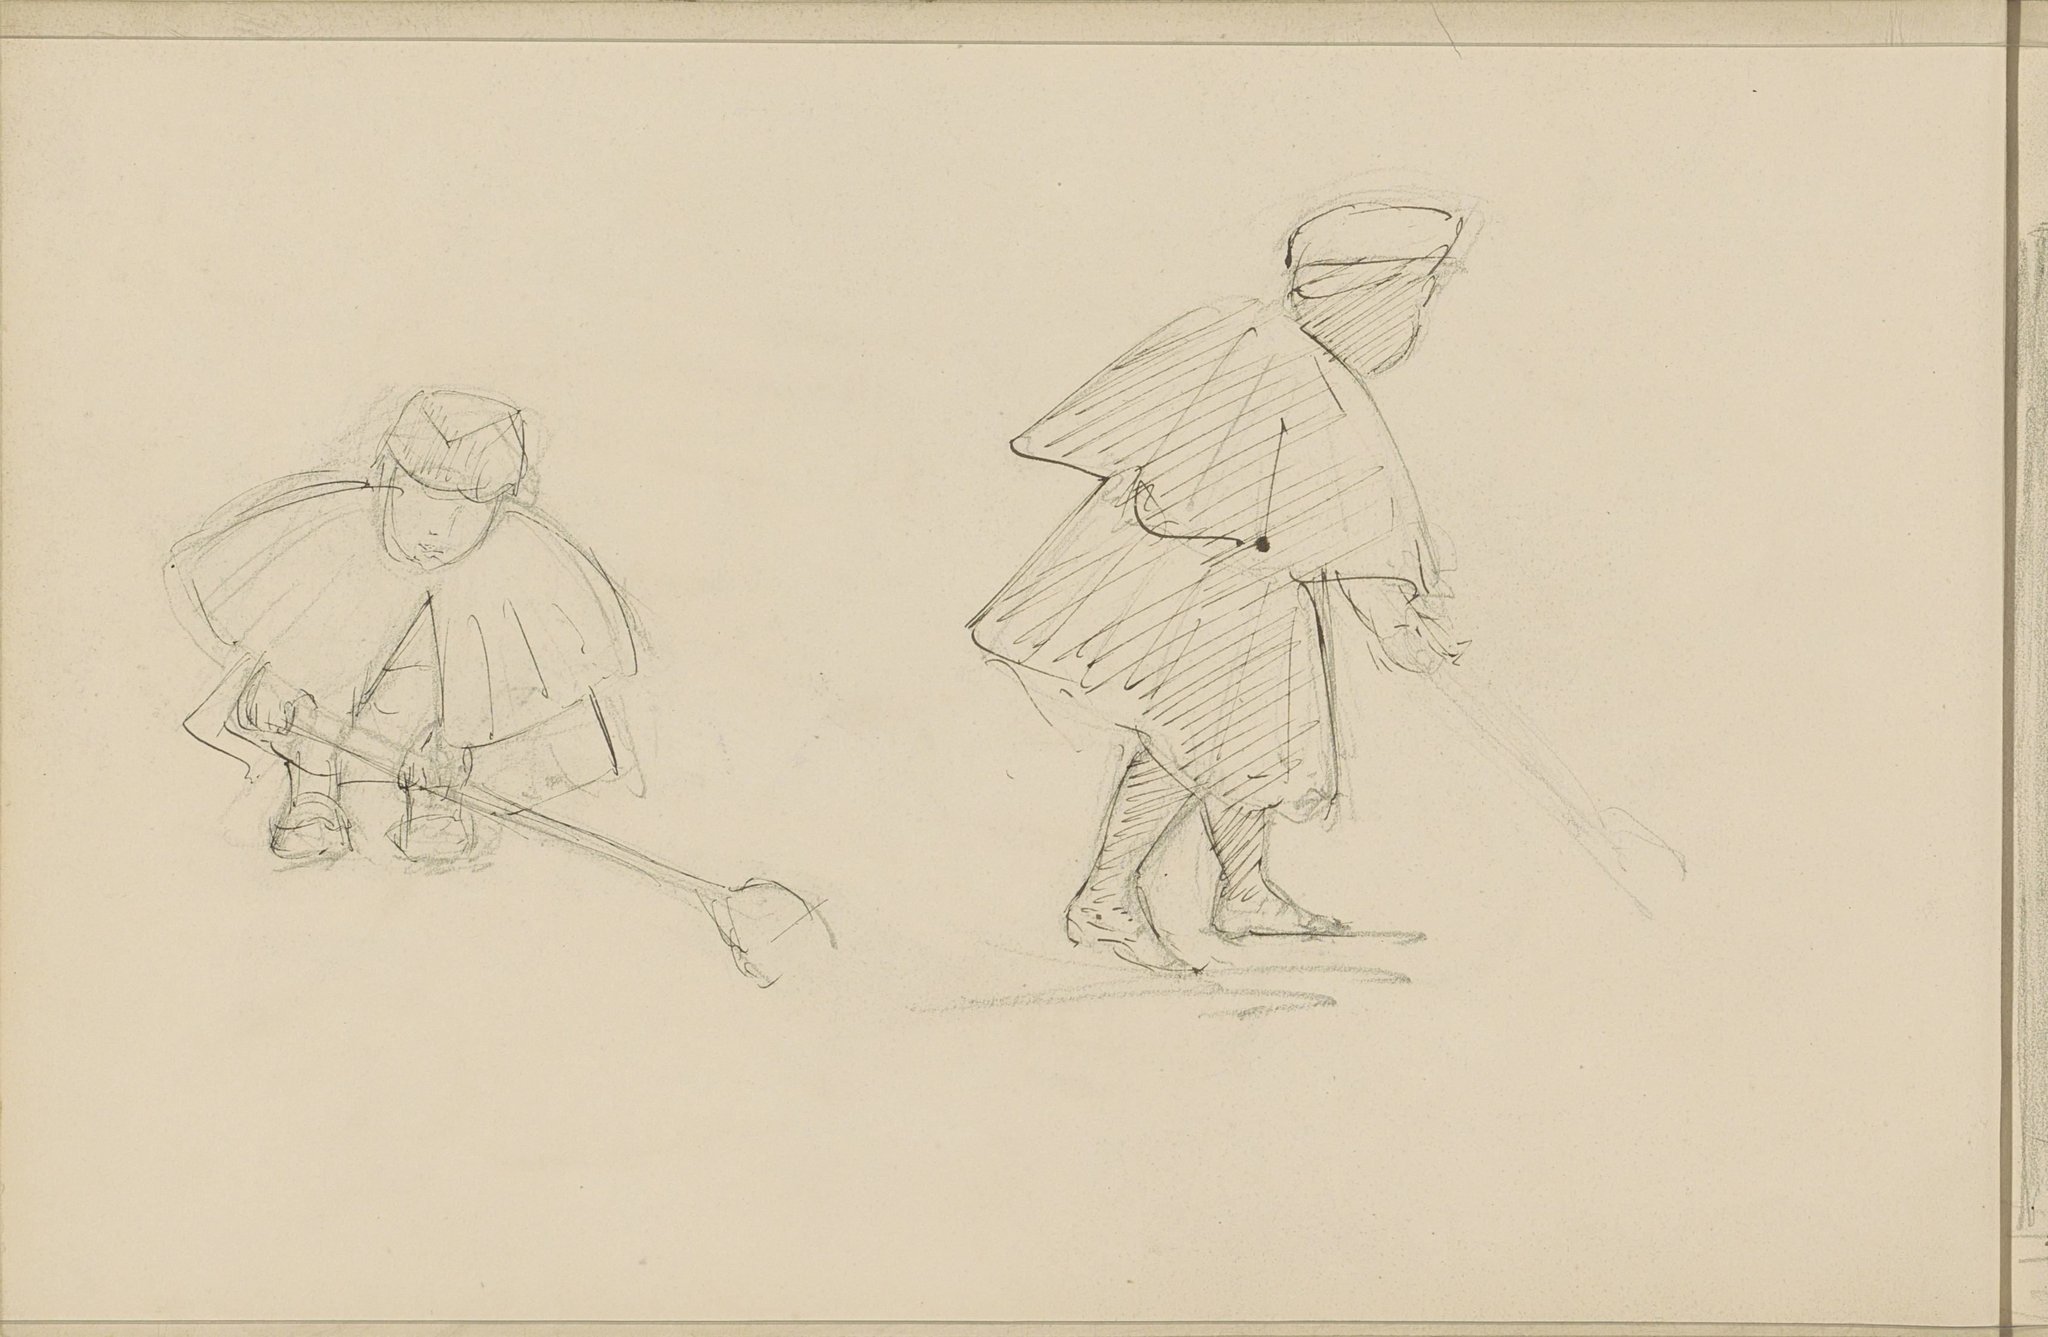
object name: sketchbook leaf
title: Kind spelend met een schep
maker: jozef israëls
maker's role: draughtsman, painter, print maker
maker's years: 1824-1911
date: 1834-1911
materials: ink, paper, pencil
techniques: pen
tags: child, playing toddler; child amusing itself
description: Het kind draagt een cape en pet. Blad 8 verso uit een schetsboek met 25 bladen.